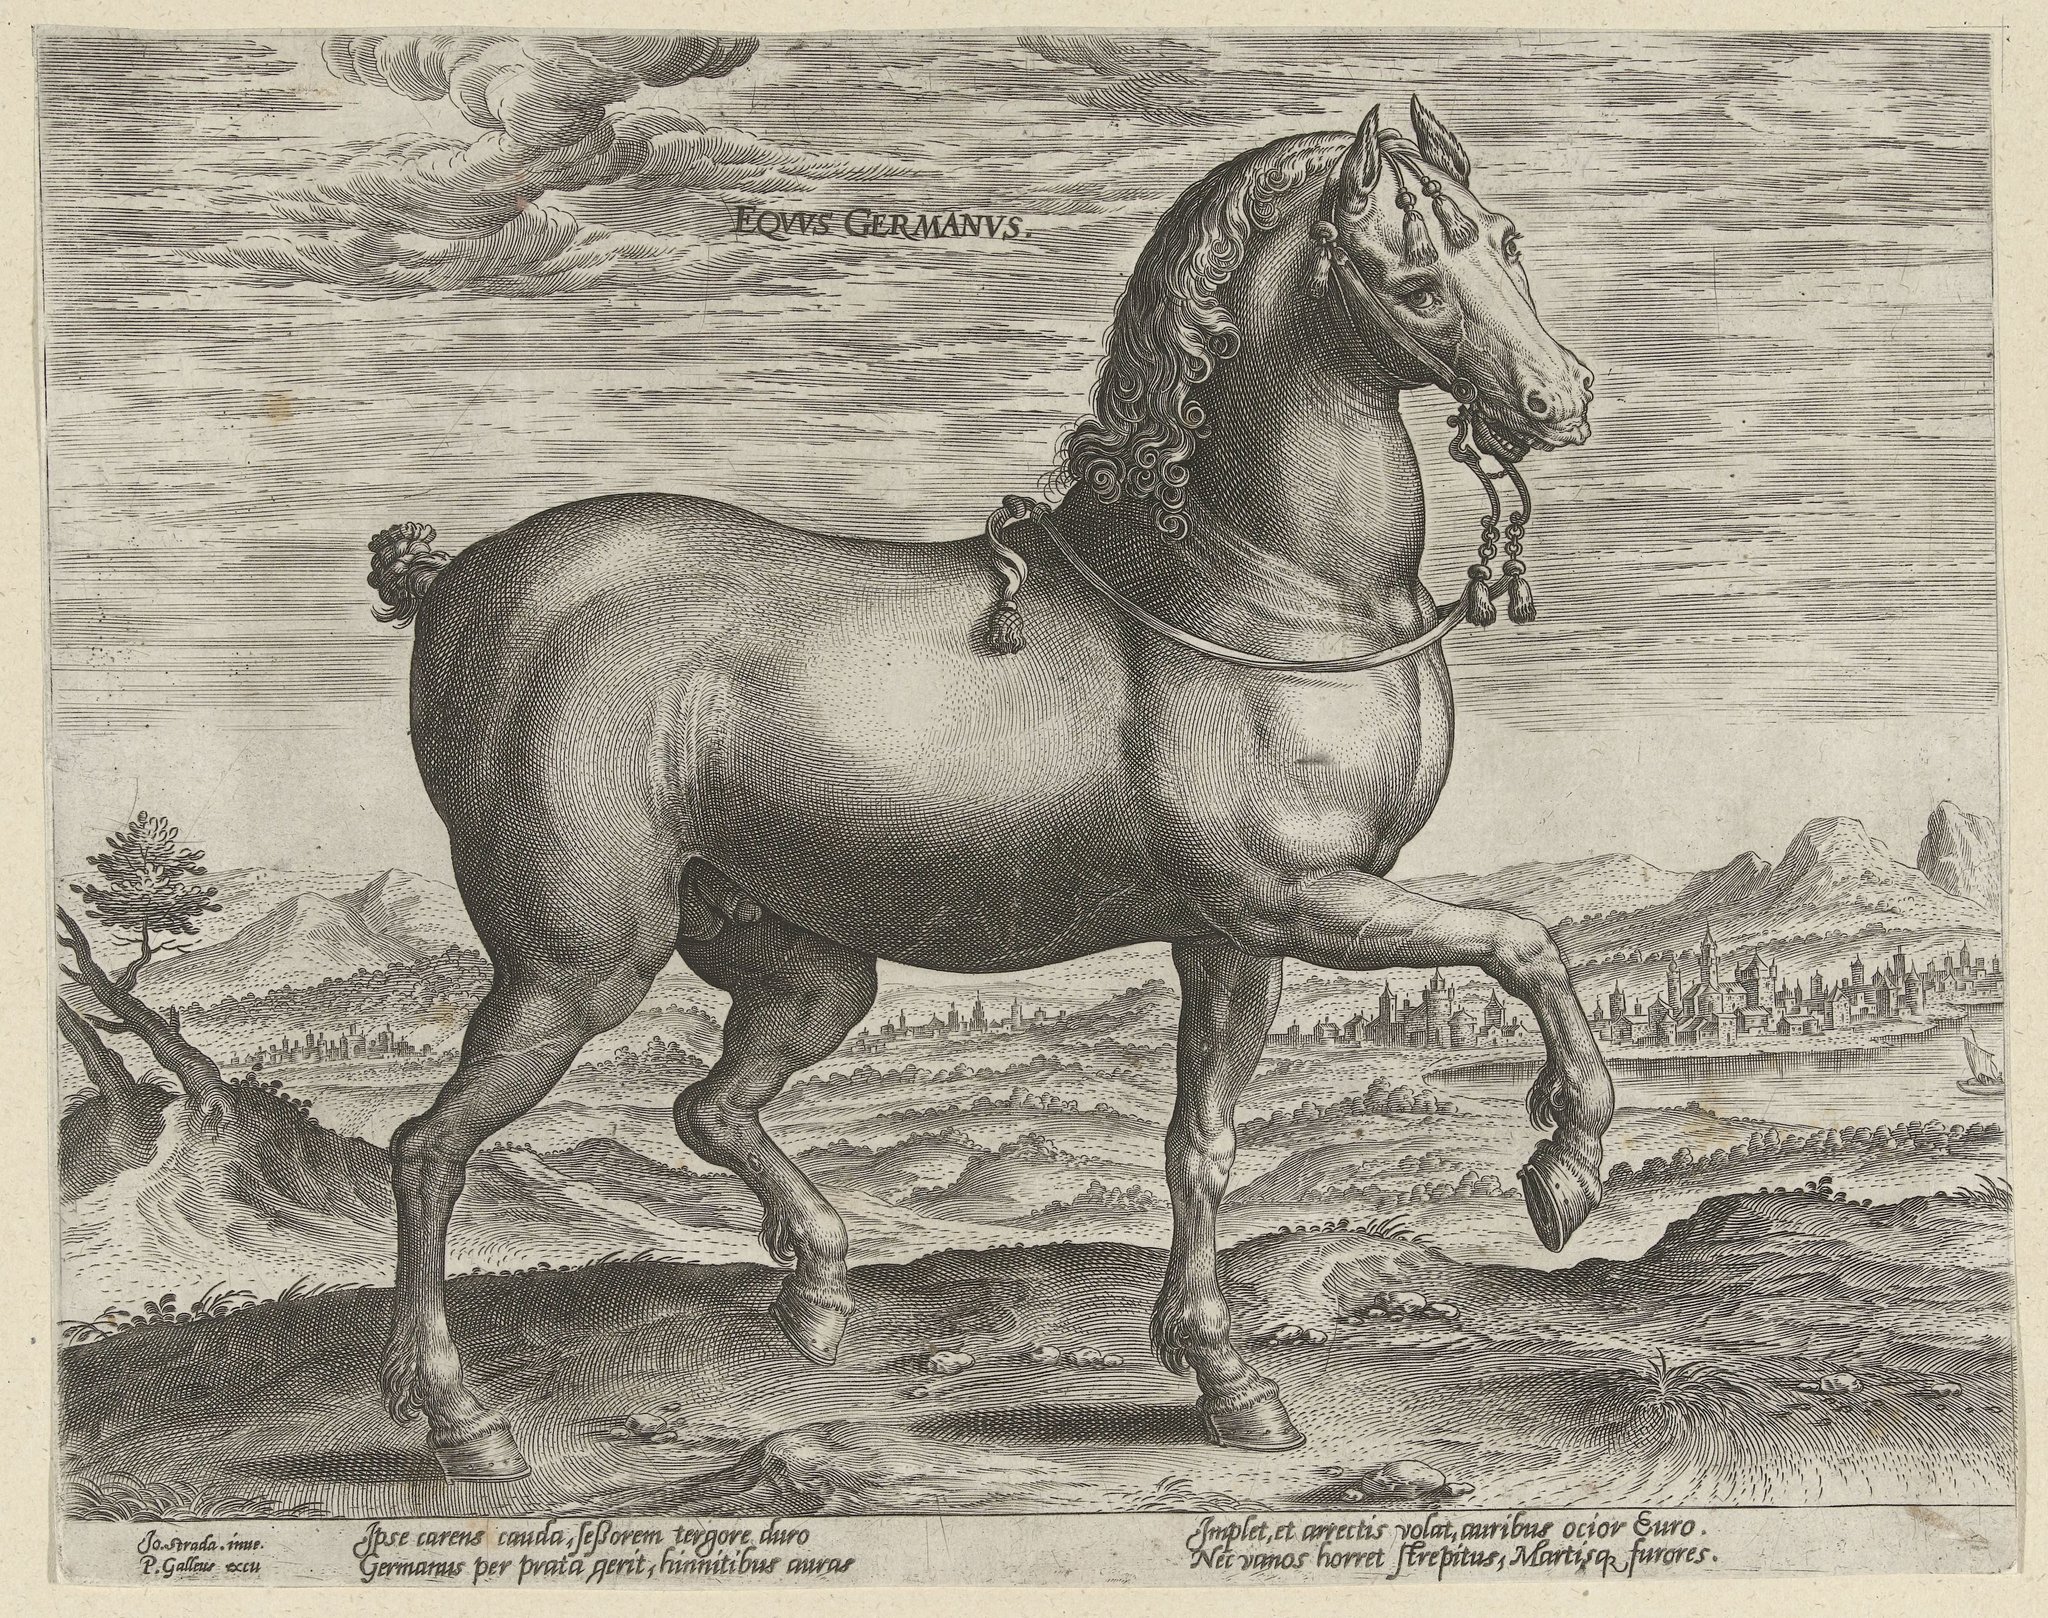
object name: print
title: Equile Ioannis Austriaci Caroli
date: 1578-1582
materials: paper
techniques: engraving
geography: antwerp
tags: don juan van oostenrijk, horses and kindred animals, germany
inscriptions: collector's mark: Lugt 89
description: Een Duits paard, in profiel. De prent heeft een Latijns onderschrift en maakt deel uit van het tweede deel van een 39-delige serie over de paardenrassen uit Koninklijke stallen van Don Juan van Oostenrijk.